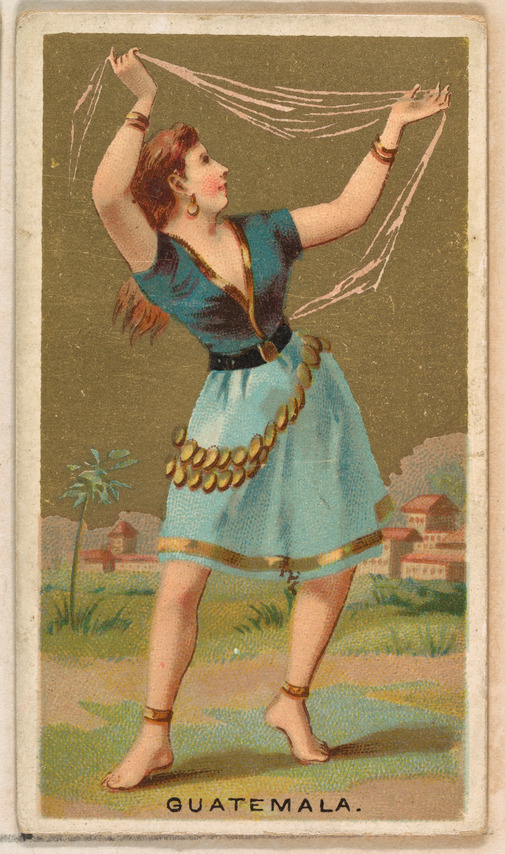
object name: print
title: Guatemala, from the Dancing Girls of the World series (N185) issued by Wm. S. Kimball & Co.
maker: william s. kimball & company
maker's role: publisher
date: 1889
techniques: color lithograph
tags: girls,profiles,dancing,dancers